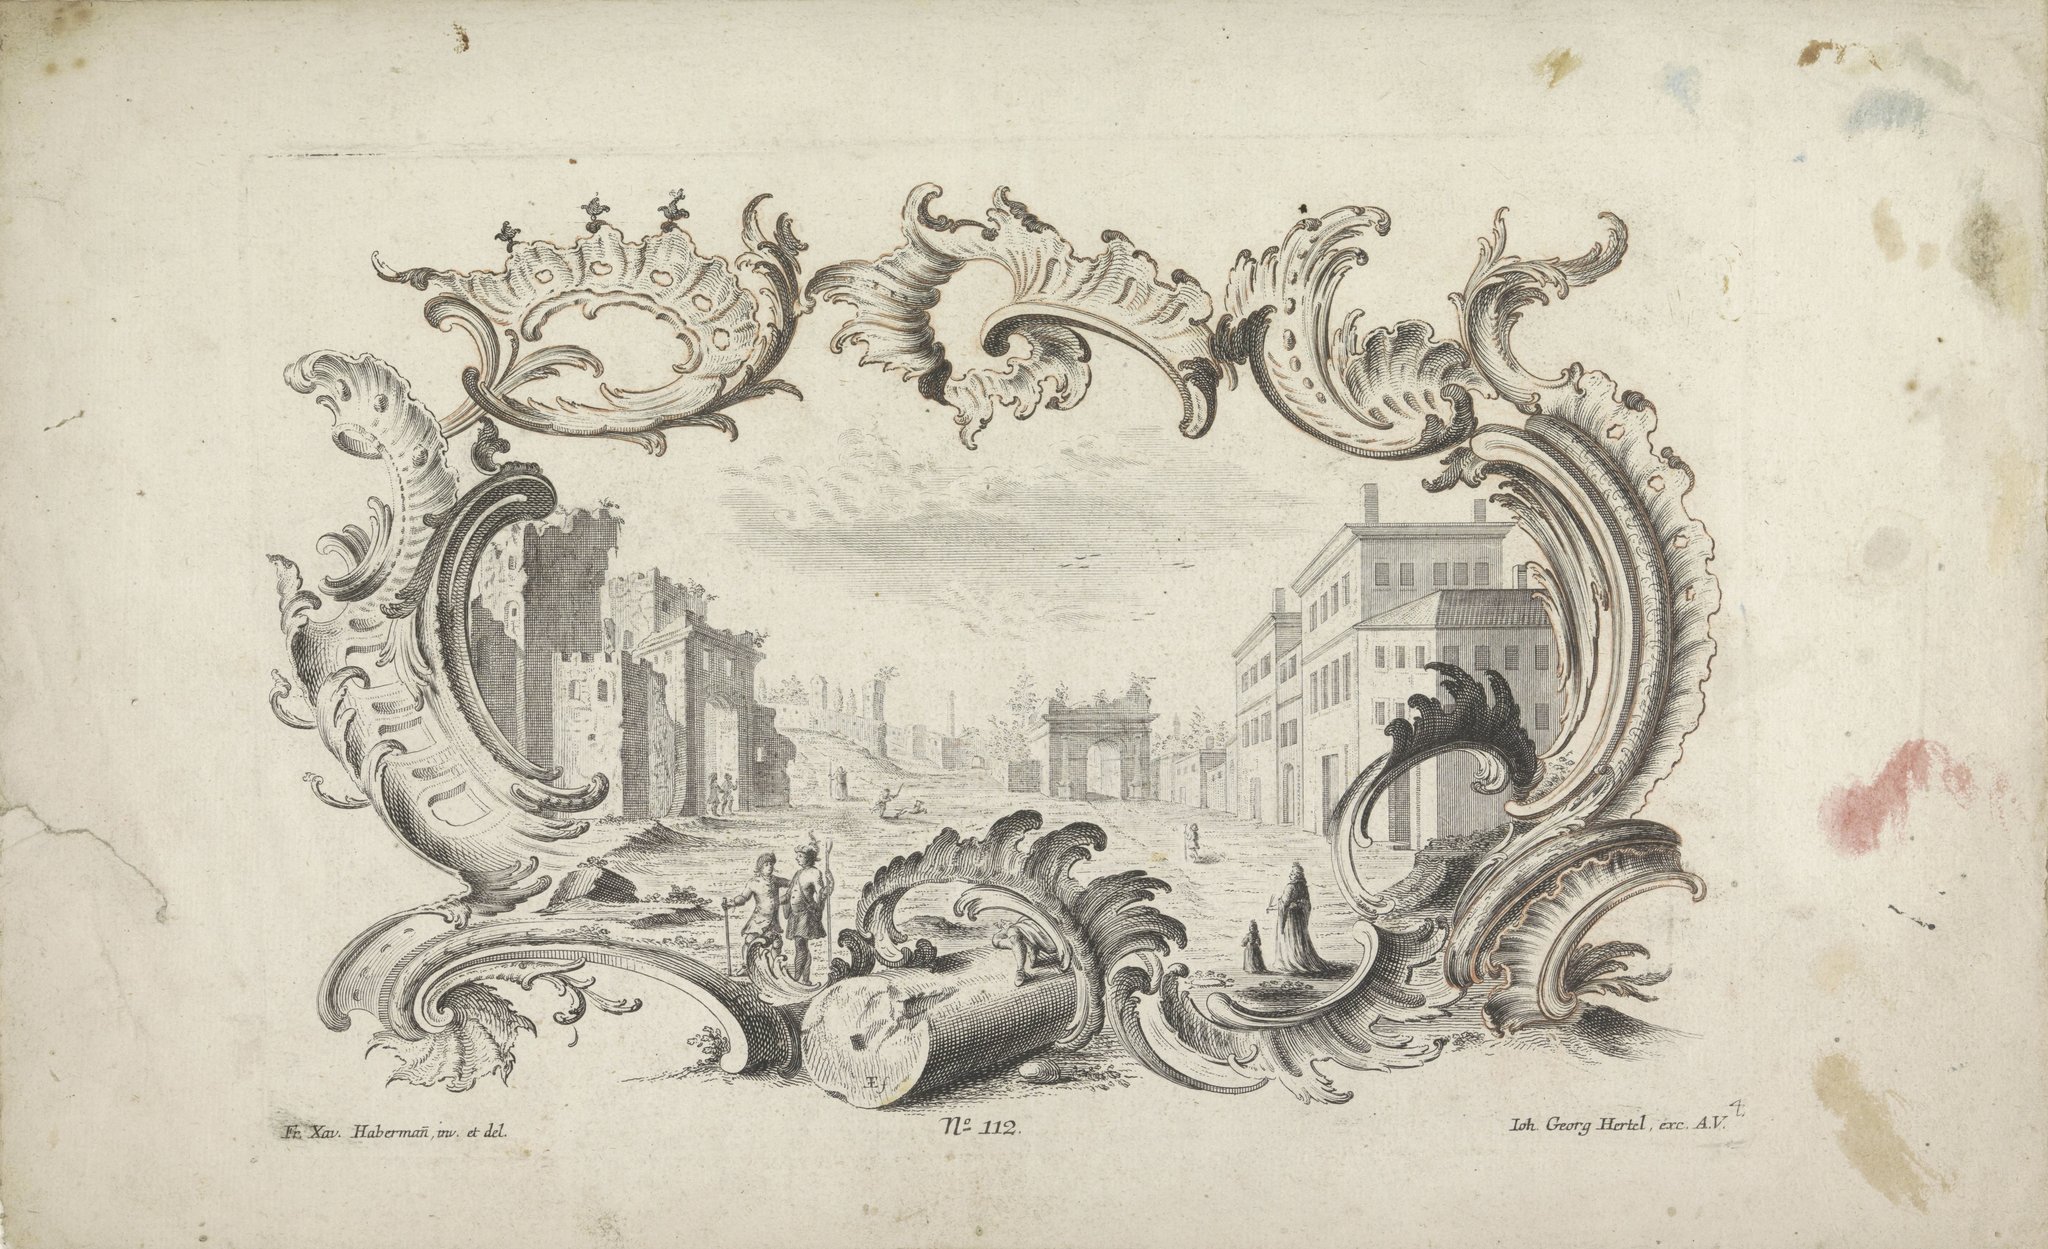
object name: ornament print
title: Ruïnes in rocaille cartouche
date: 1731-1775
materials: paper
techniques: engraving, etching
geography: augsburg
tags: rocaille ornament, landscape with ruins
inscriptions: collector's mark: Lugt 2228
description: Figuren in een landschap met links ruïnes en rechts gebouwen. In rocaille omlijsting. Uitgeversnummer 112.